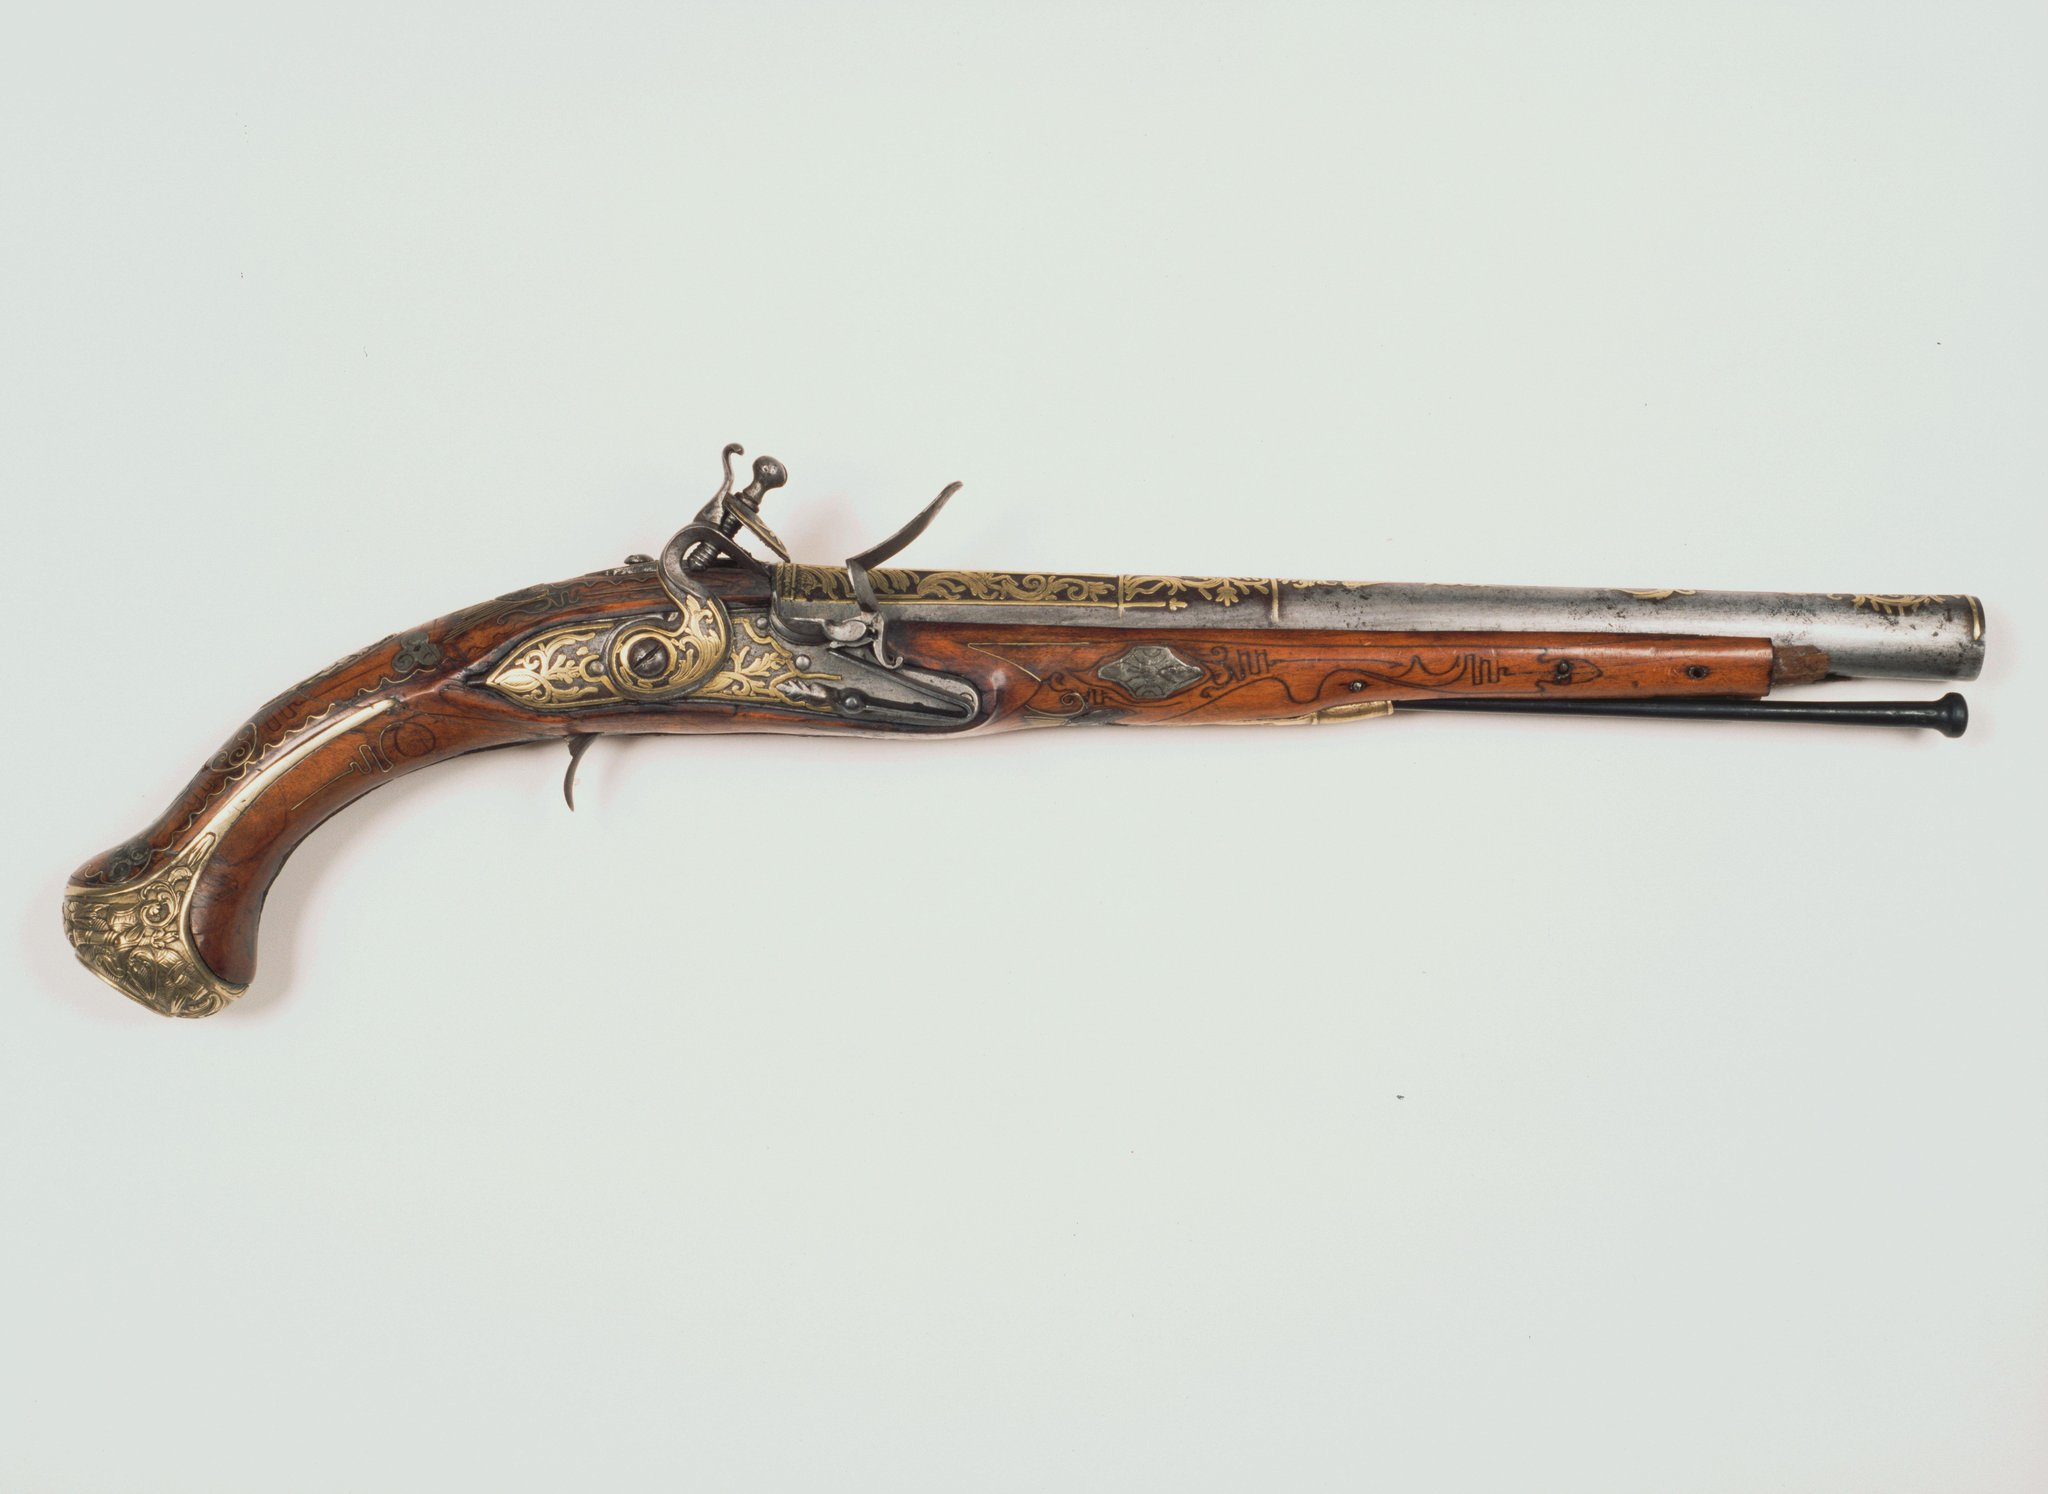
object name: flintlock pistol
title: Ruiterpistool met vuursteenslot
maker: Anonymous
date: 1675-1700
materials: copper, iron, silver, wood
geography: western europe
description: Ruiterpistool met vuursteenslot, de ijzeren ronde loop, over de gehele lengte bewerkt met koperen ornamenten, eindigt achthoekig. Vuursteenslot is geheel van ijzer met koperen ornamenten, de bovenzijde van de haan is eveneens versierd met een koperen ornament , het vuurstaal is geribbeld. De houten lade is door ingebrande lijnen versierd met motieven en heeft ingelegde zilveren ornamenten. De houten kolf heeft een met koperen versierde kolfplaat van rocaille-werk. De hals van de kolf is geornamenteerd met dunne lijnen van messing die in sierlijke vormen over de gehele lengte van de hals lopen. De trekkerbeugel ontbreekt, een kleine ijzeren trekker aan de onderzijde van het pistool. Aan de linkerzijde van het pistool koperen beslag .Onder de lade een laadstokkoker met koperen uiteinde en waarin zich een houten zwart geverfde laadstok bevindt. Aan de linkerzijde van de lade drie gaten waarvan er in de meest rechter een ijzeren pin bevindt, de overige twee pinnen ontbreken.